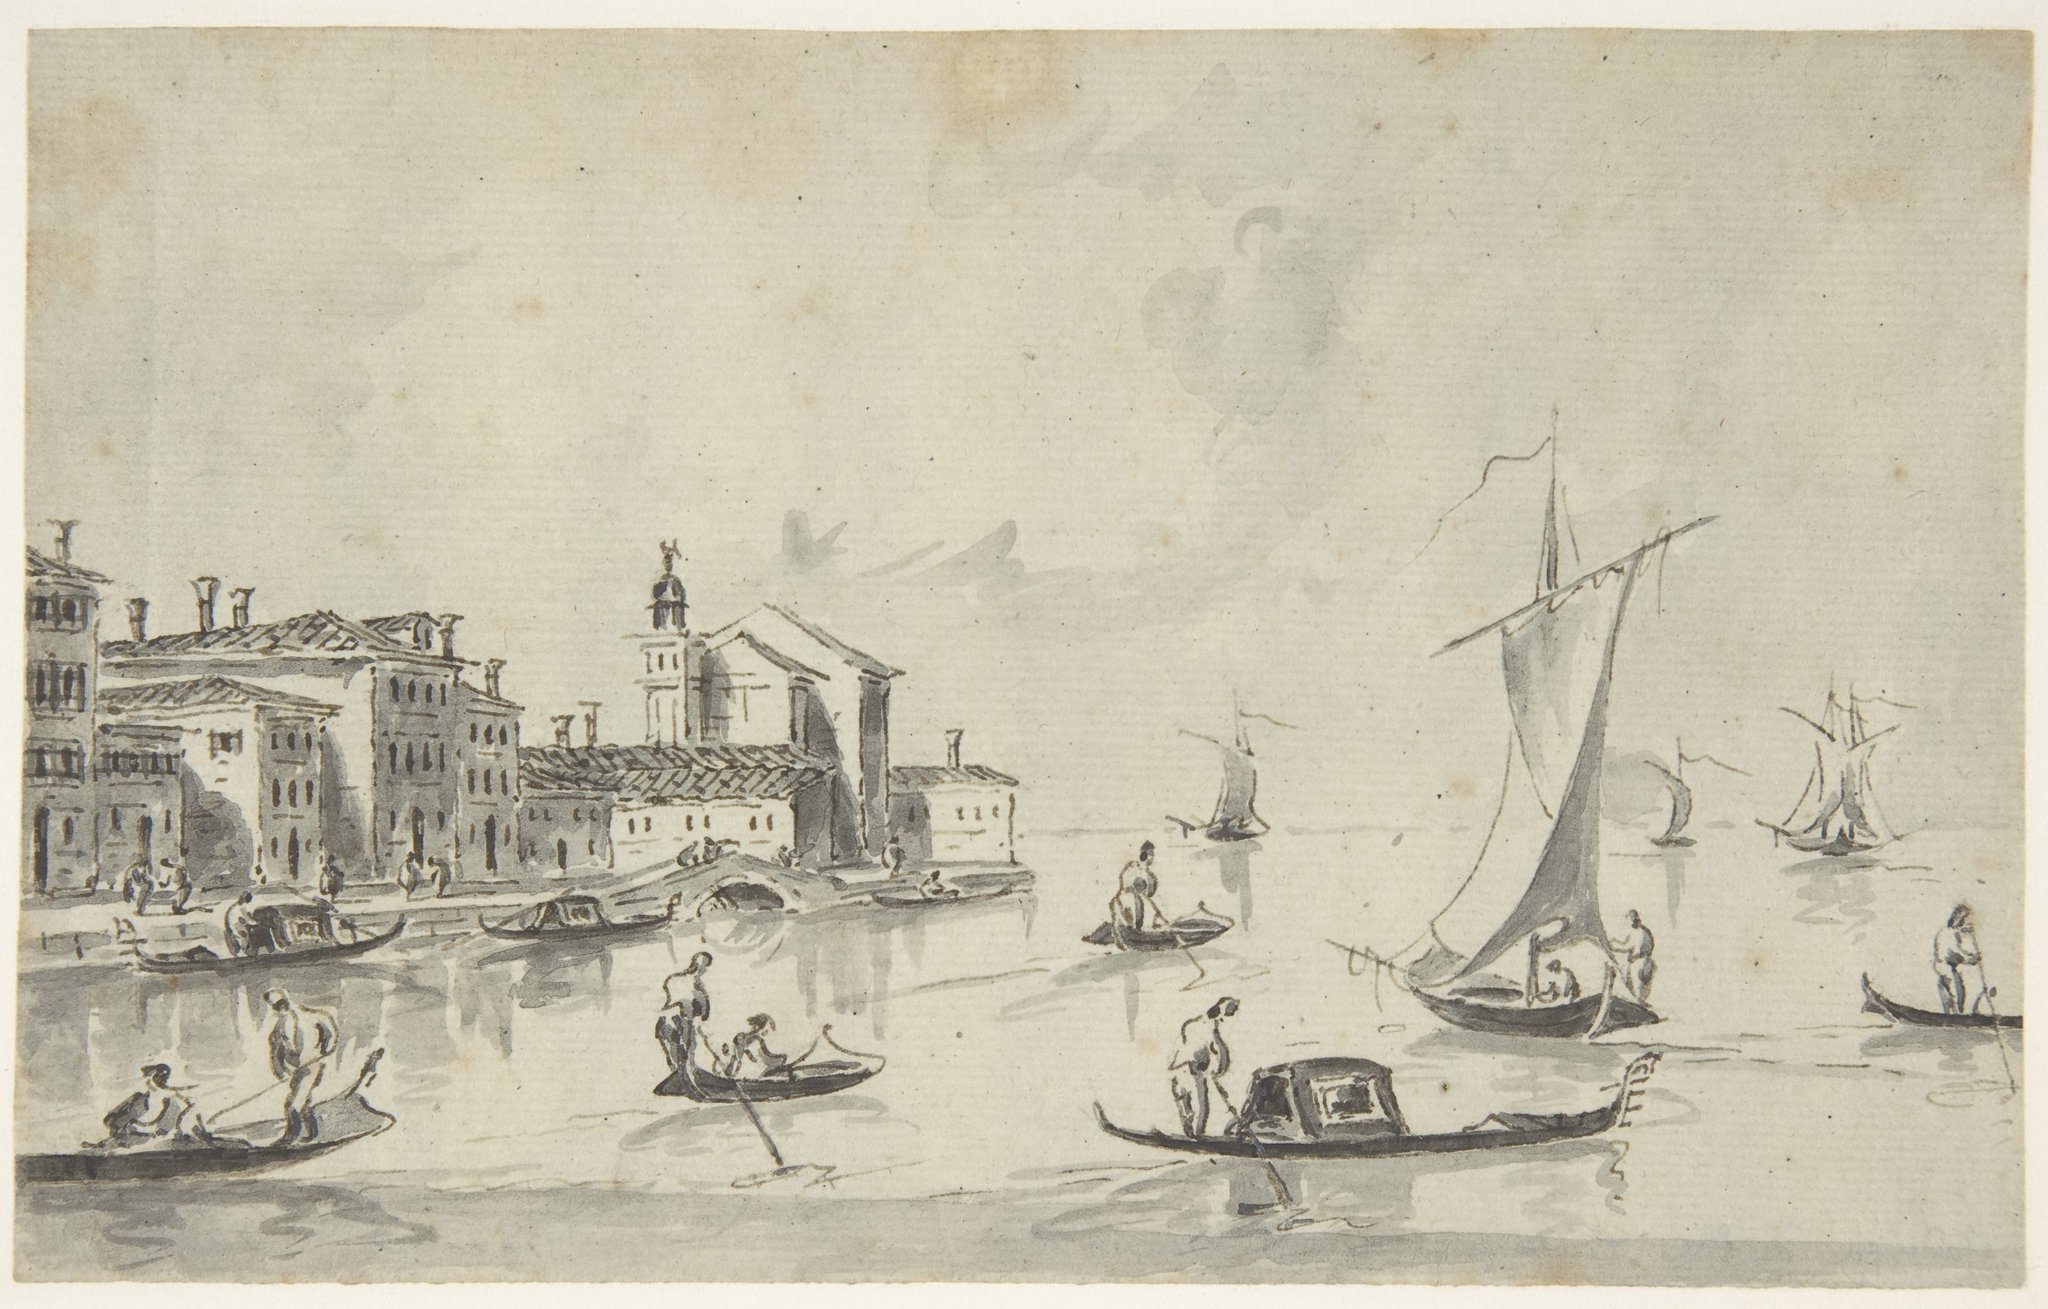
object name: drawing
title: San Biagio on the Giudecca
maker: giacomo guardi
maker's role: artist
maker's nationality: italian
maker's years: 1764-1835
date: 1764-1835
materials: ink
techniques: brush, pen, wash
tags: human figures,buildings,boats